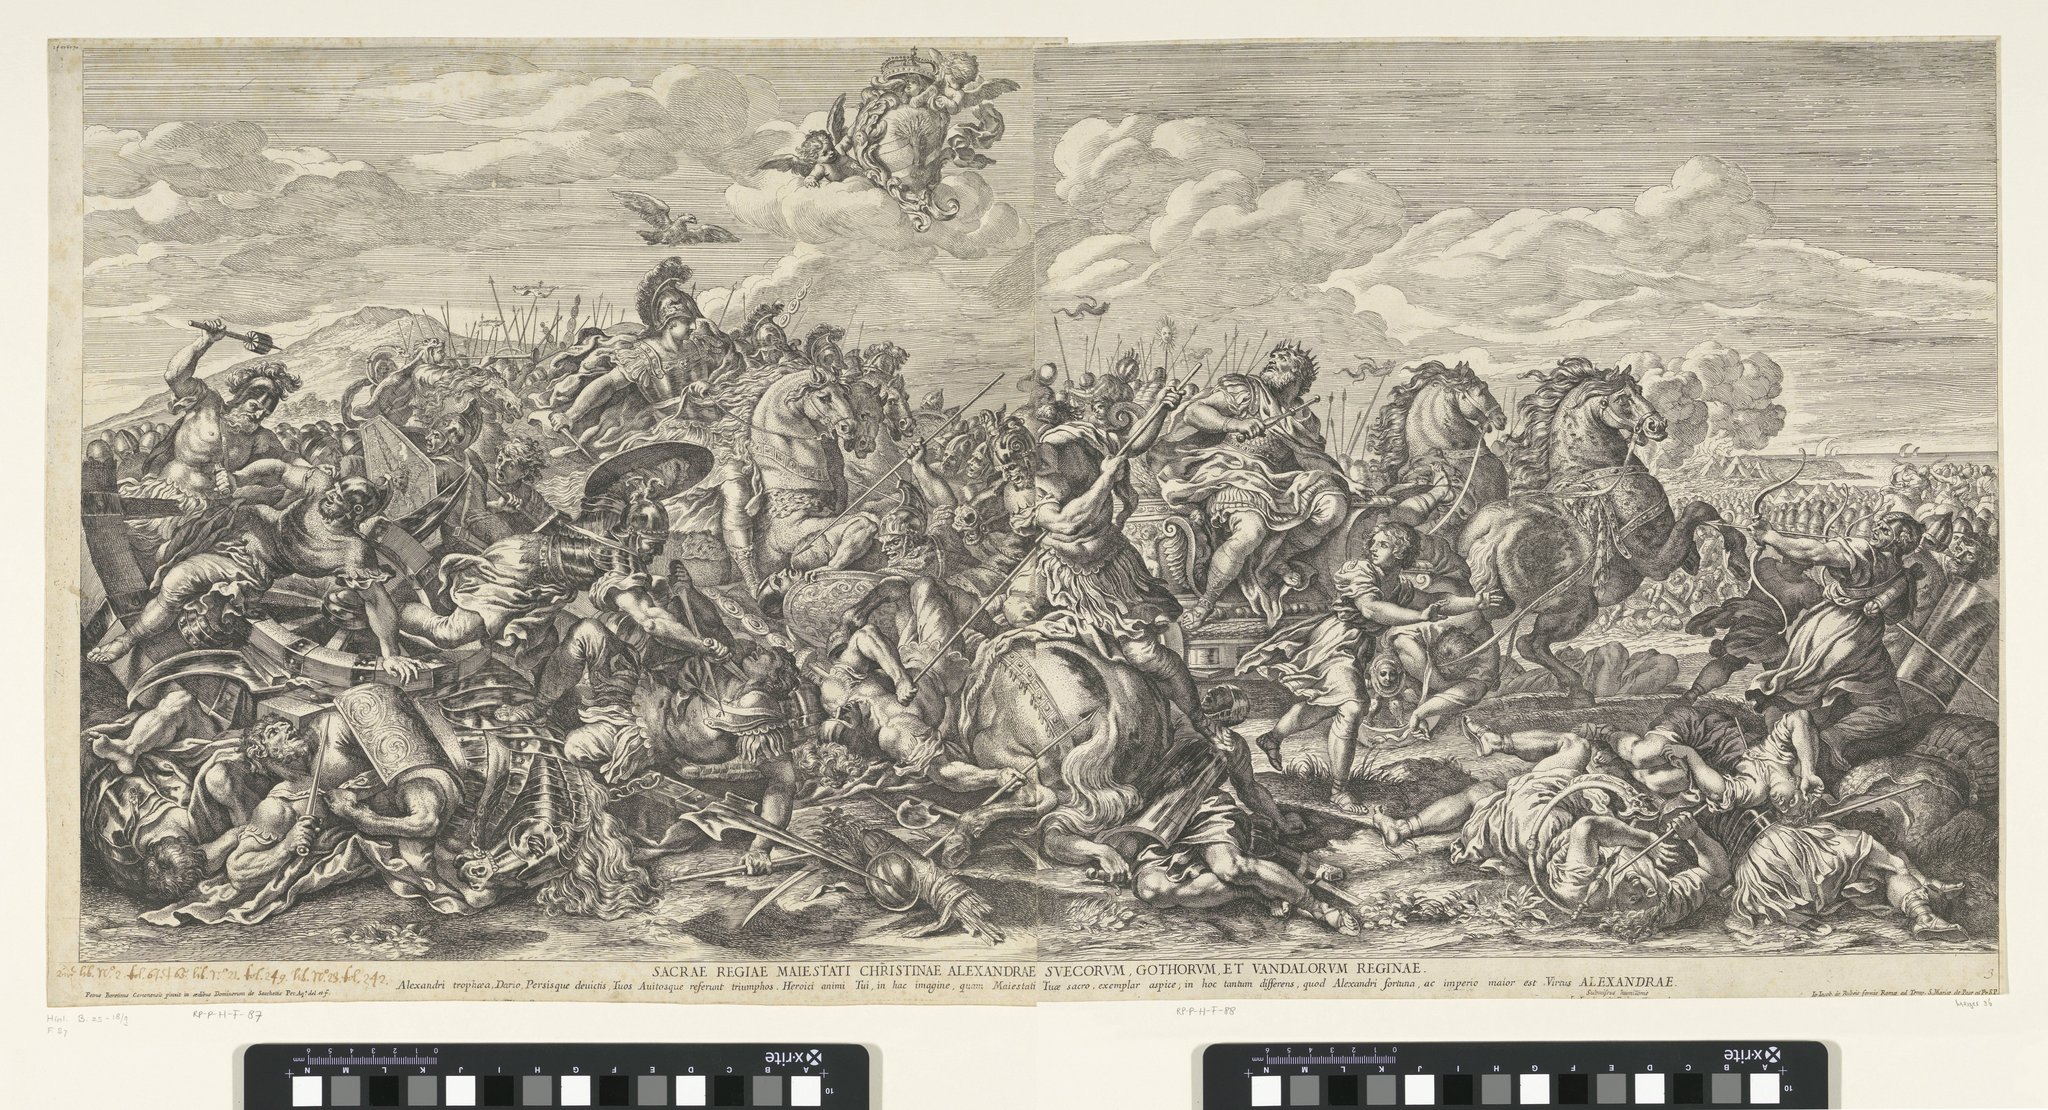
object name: print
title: Slag bij Arbella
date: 1660-1692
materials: paper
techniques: etching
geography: vatican city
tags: battle, (story of) alexander the great, warfare; military affairs (+ cavalry, horsemen), the soldier; the soldier's life, fighting, (story of) darius, king of persia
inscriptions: collector's mark: Lugt 240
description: De slag tussen de legers van Alexander de Grote en Darius bij Arbella.